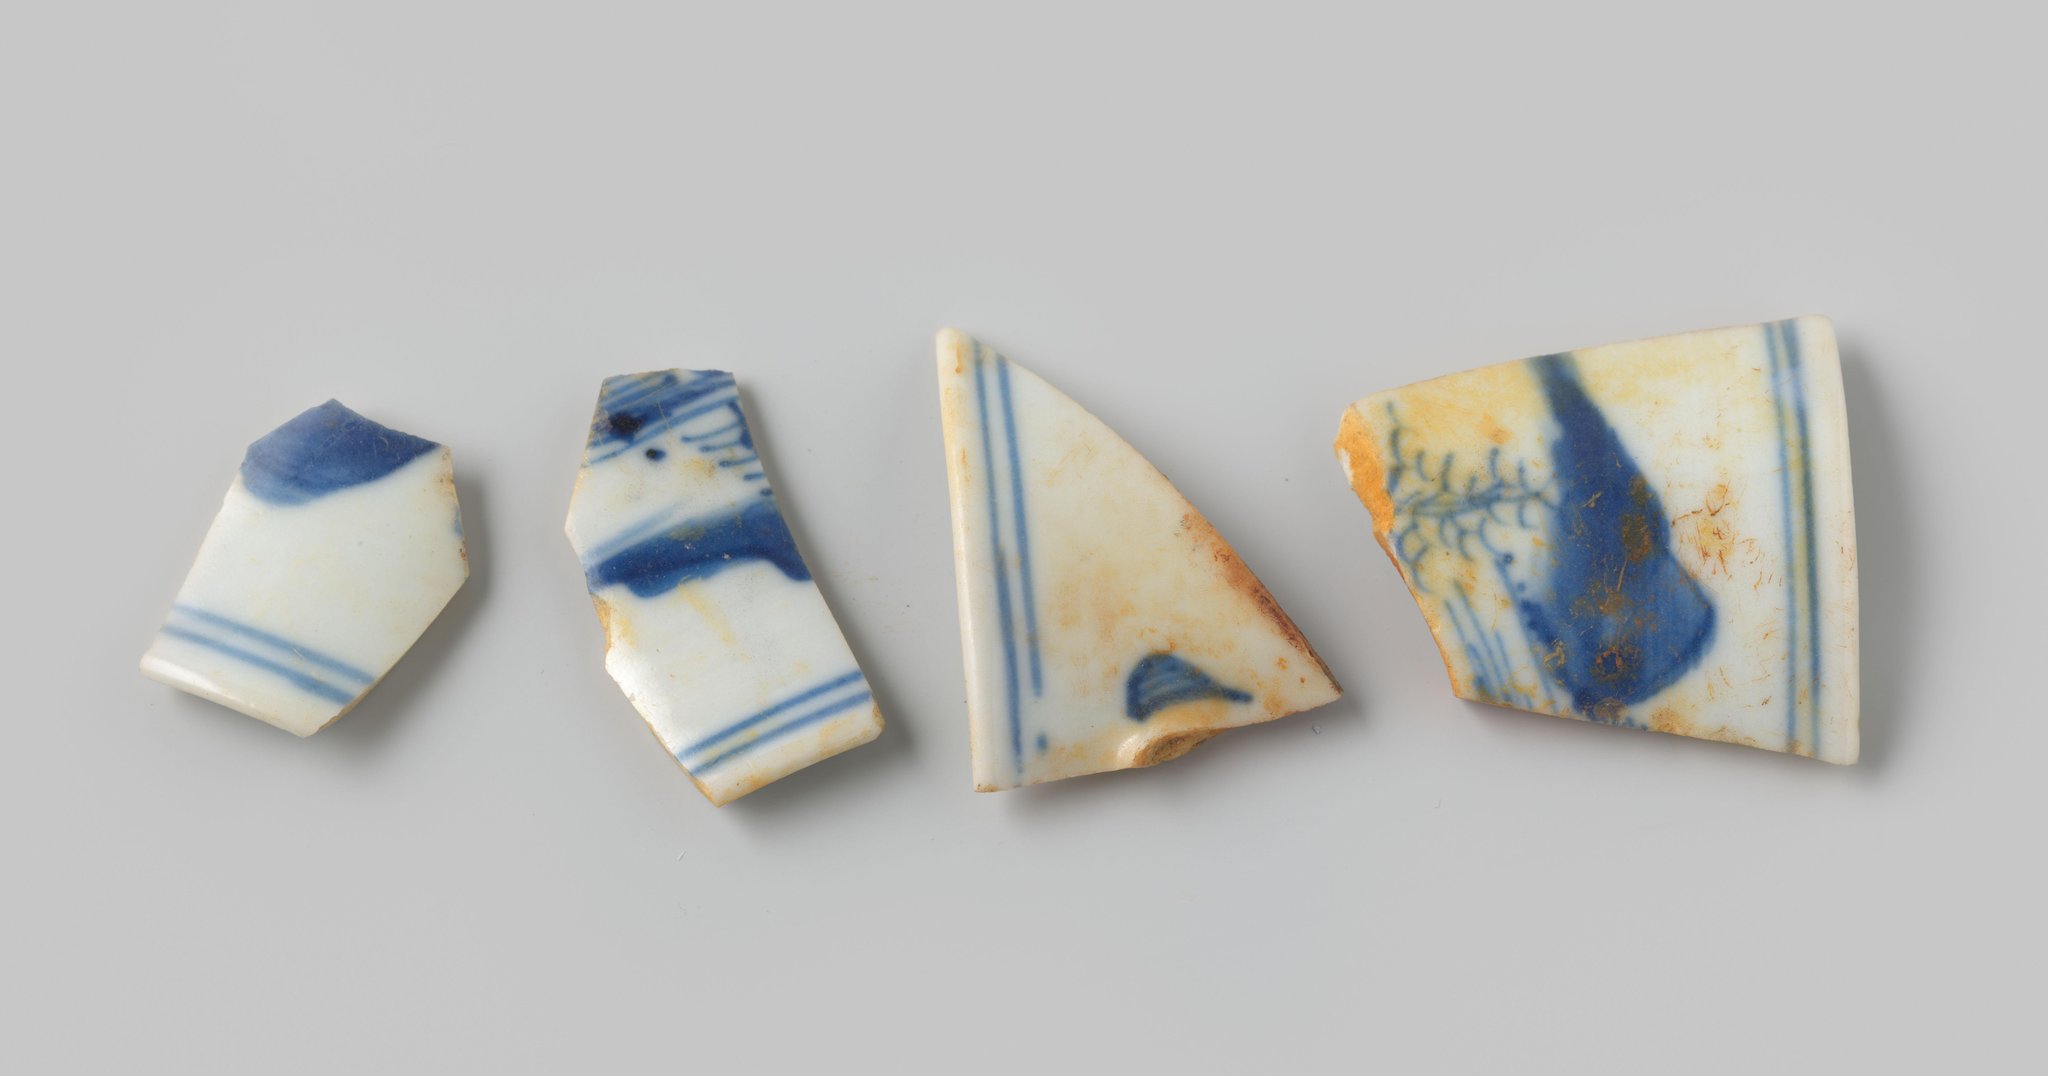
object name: cup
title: Scherven van een kop uit het wrak van de Oost-Indiëvaarder Hollandia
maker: Anonymous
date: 1700-1743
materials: porcelain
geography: netherlands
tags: verenigde oostindische compagnie, hollandia (schip), annet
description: Porcelain, cup, type 2; fragm of body with rim, fragm with join of handle.